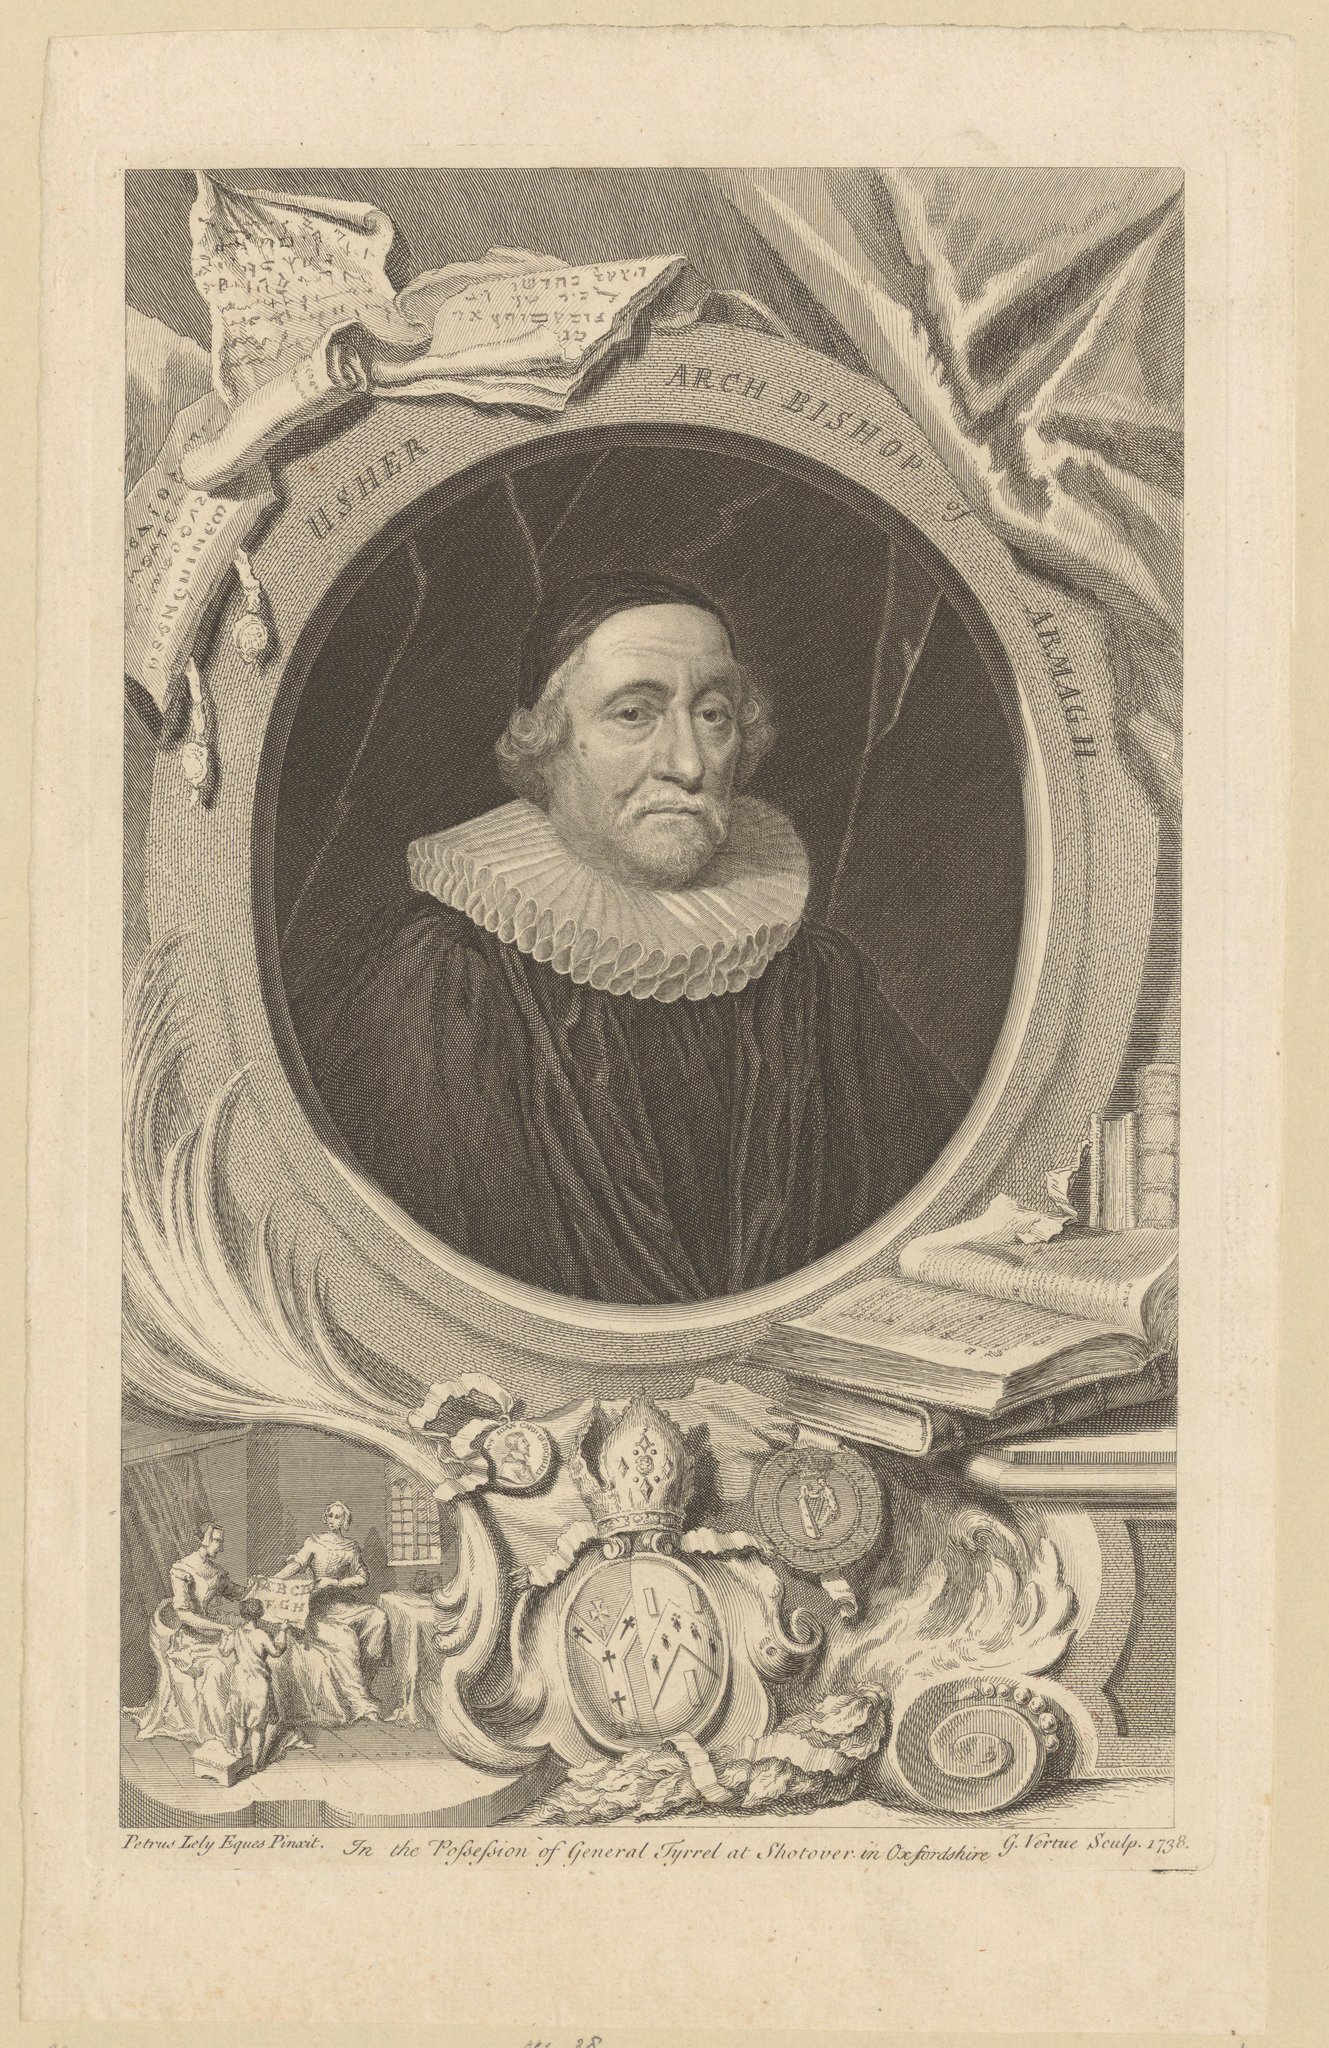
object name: book illustration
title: Usher Archbishop of Armagh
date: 1738-1747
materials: paper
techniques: engraving, etching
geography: london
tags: archbishop, bishop, etc. (roman catholic), historical persons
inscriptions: collector's mark: Lugt 240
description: Prent gebruikt in: Birch, Thomas. The heads of illustrious persons of Great Britain (...). Londen: John & Paul Knapton, 1747, p. 74.